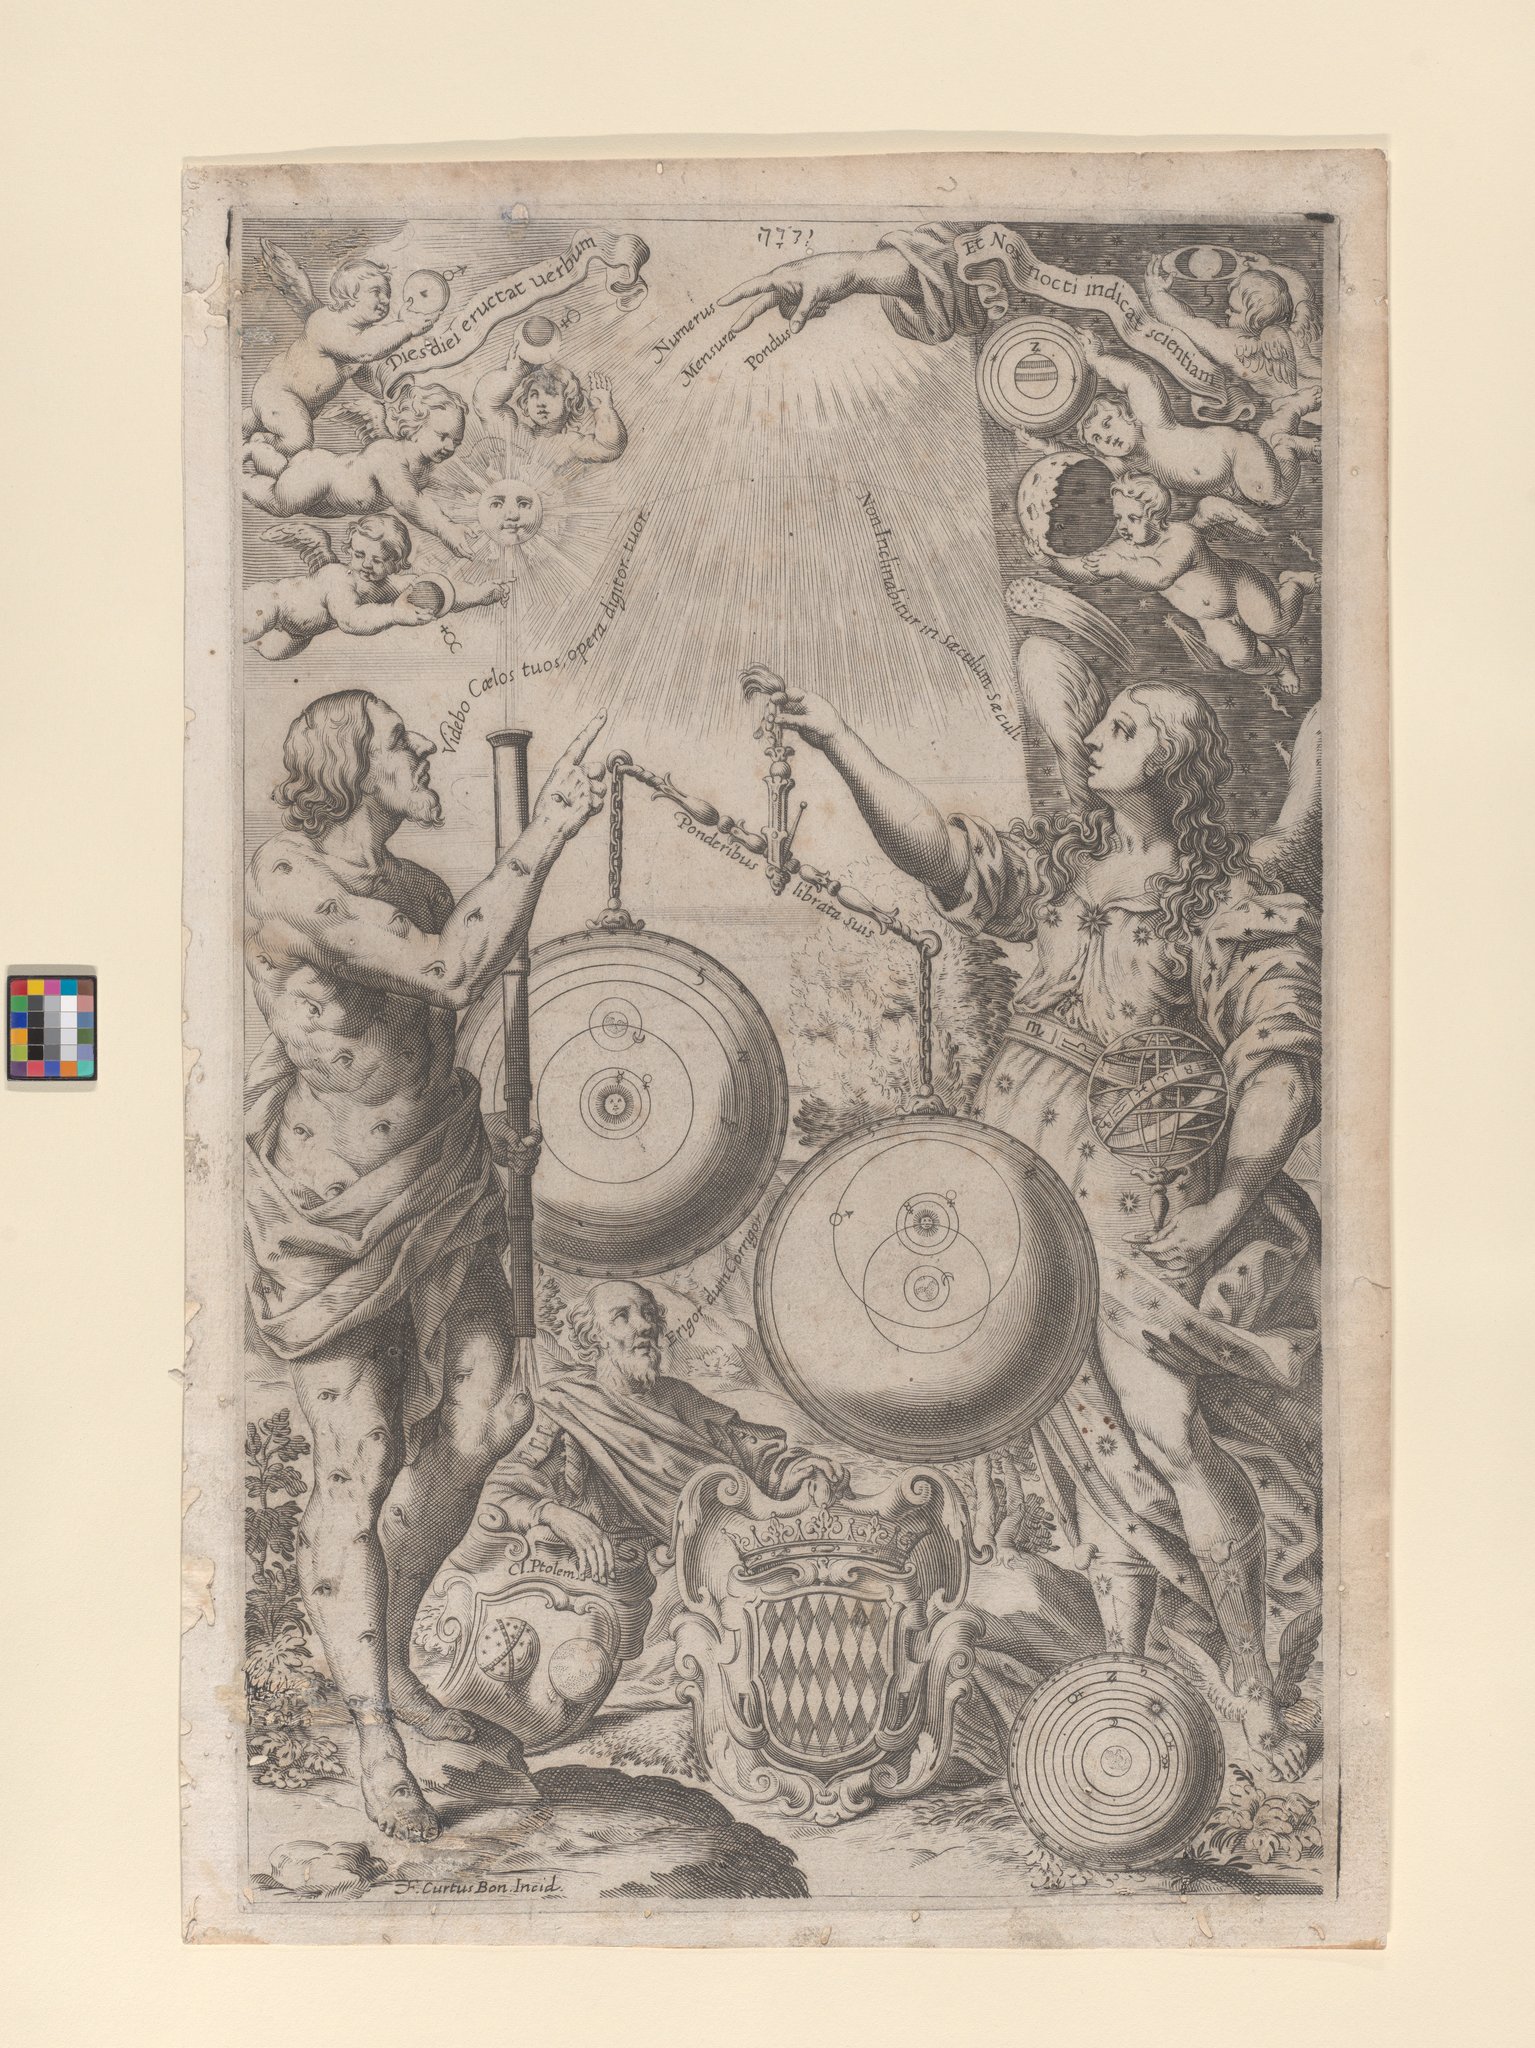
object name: print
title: Frontispiece: mythological figures weigh astronomical theories, from "The New Almagest" (Almagestum Novum)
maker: francesco curti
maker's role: artist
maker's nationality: italian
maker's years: 1603-1670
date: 1651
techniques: engraving